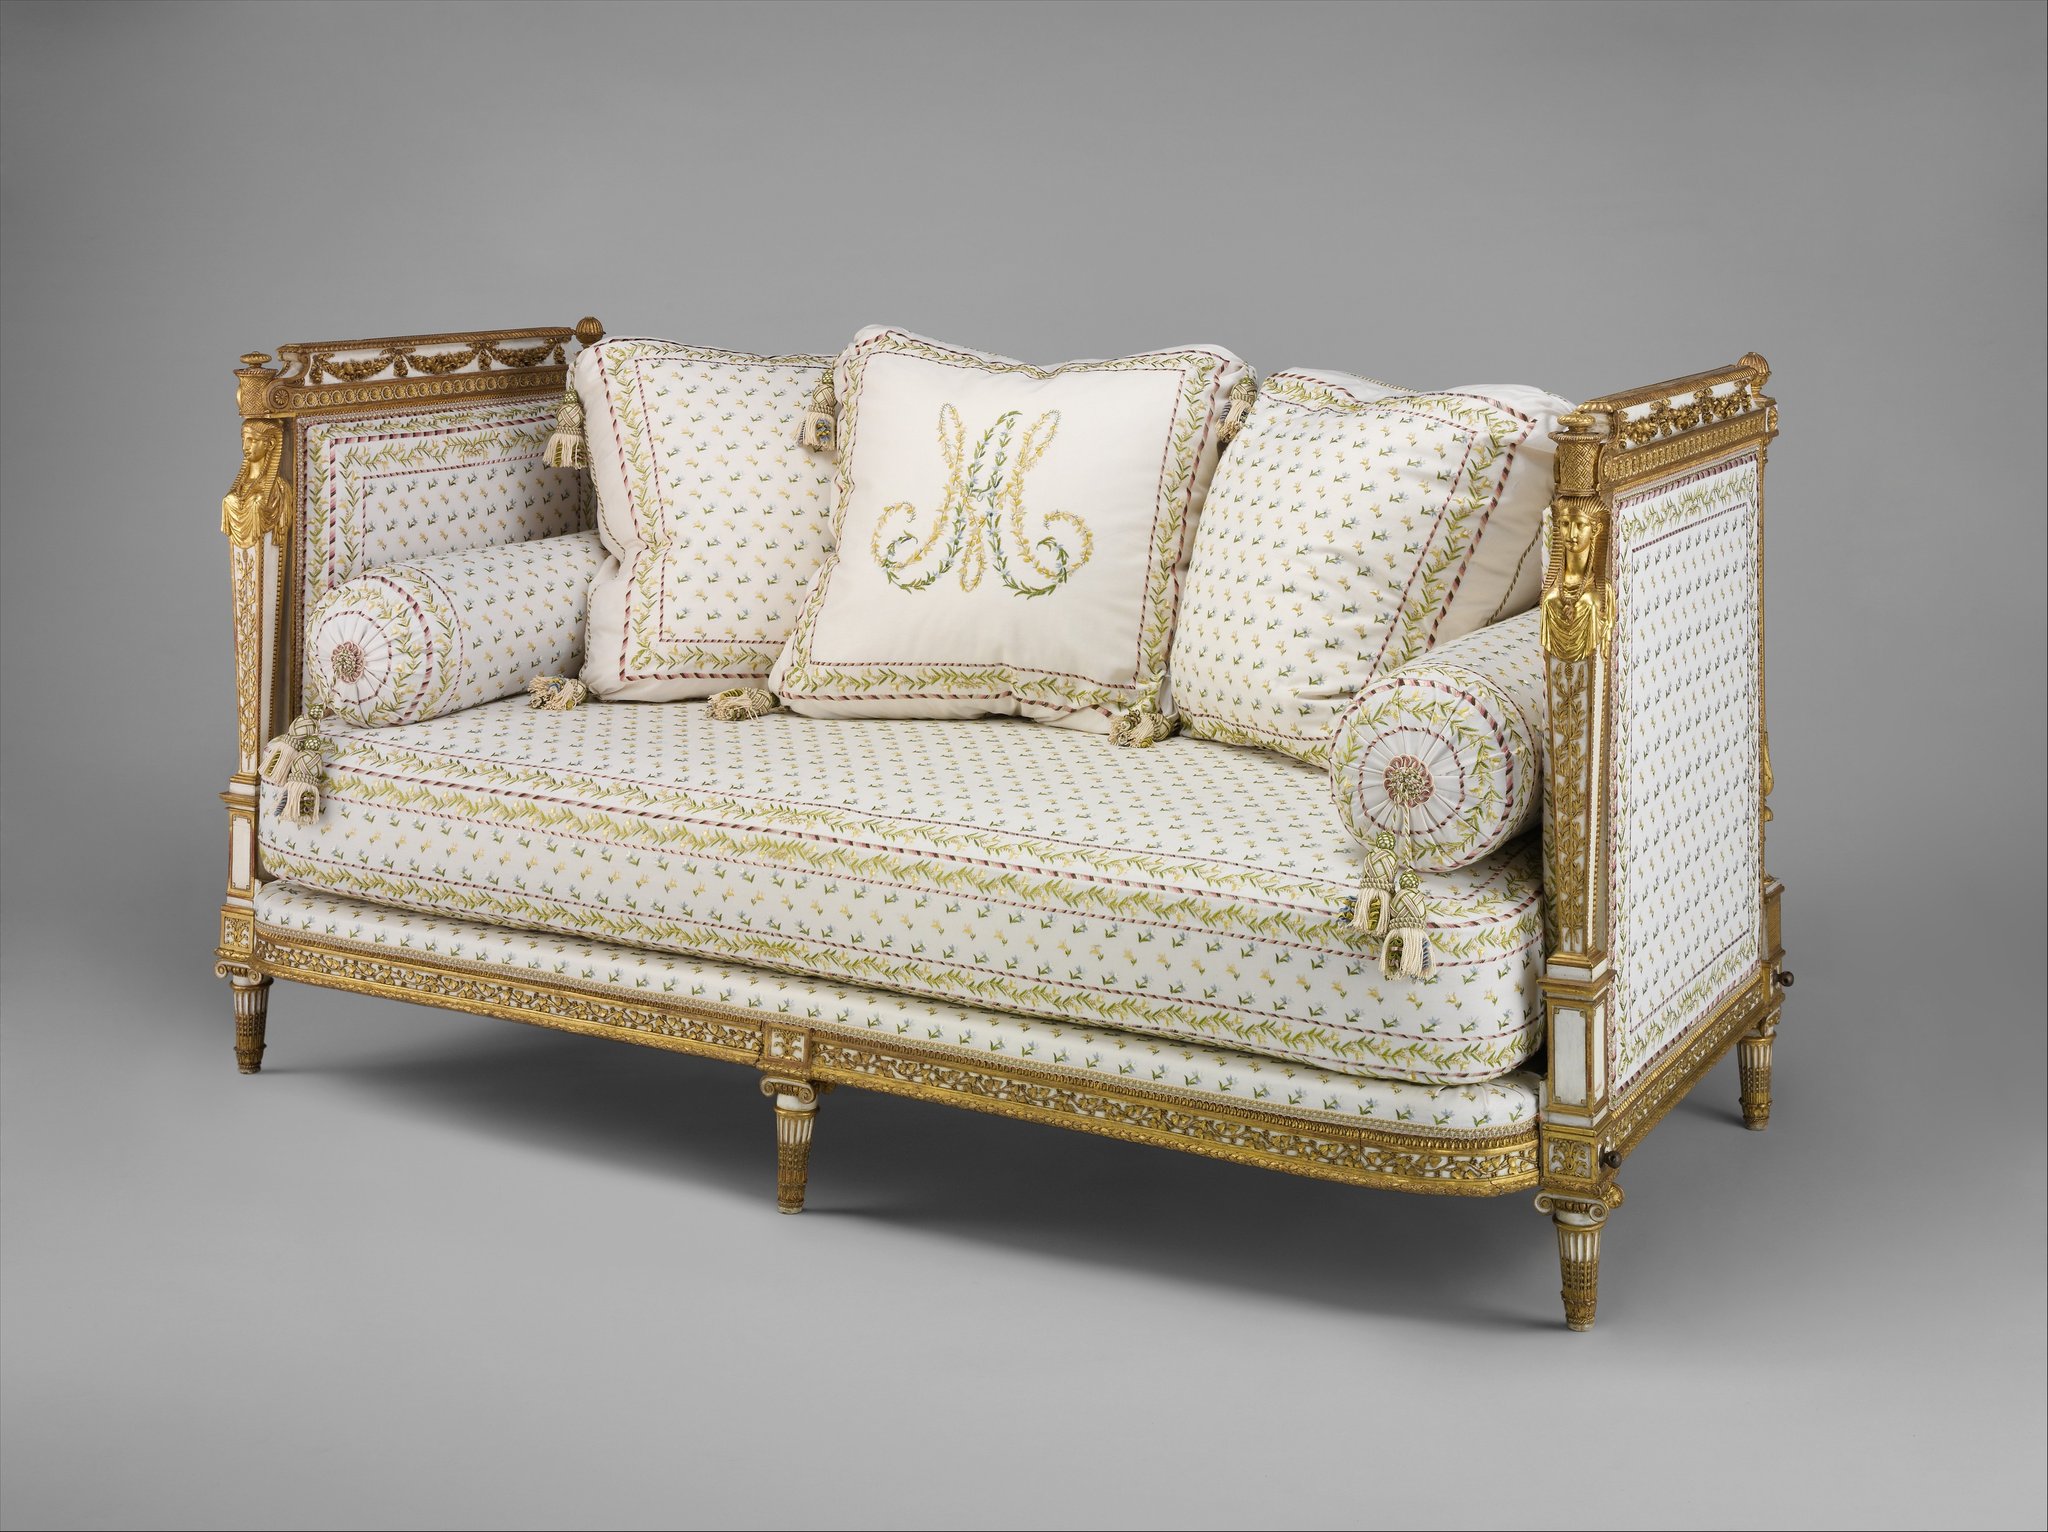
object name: daybed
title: Daybed (Lit de repos or sultane) (part of a set)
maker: jean-baptiste-claude sené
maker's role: maker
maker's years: 1748-1803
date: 1788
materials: cotton, silk, wood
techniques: carving, embroidery, gilding, painting, weave